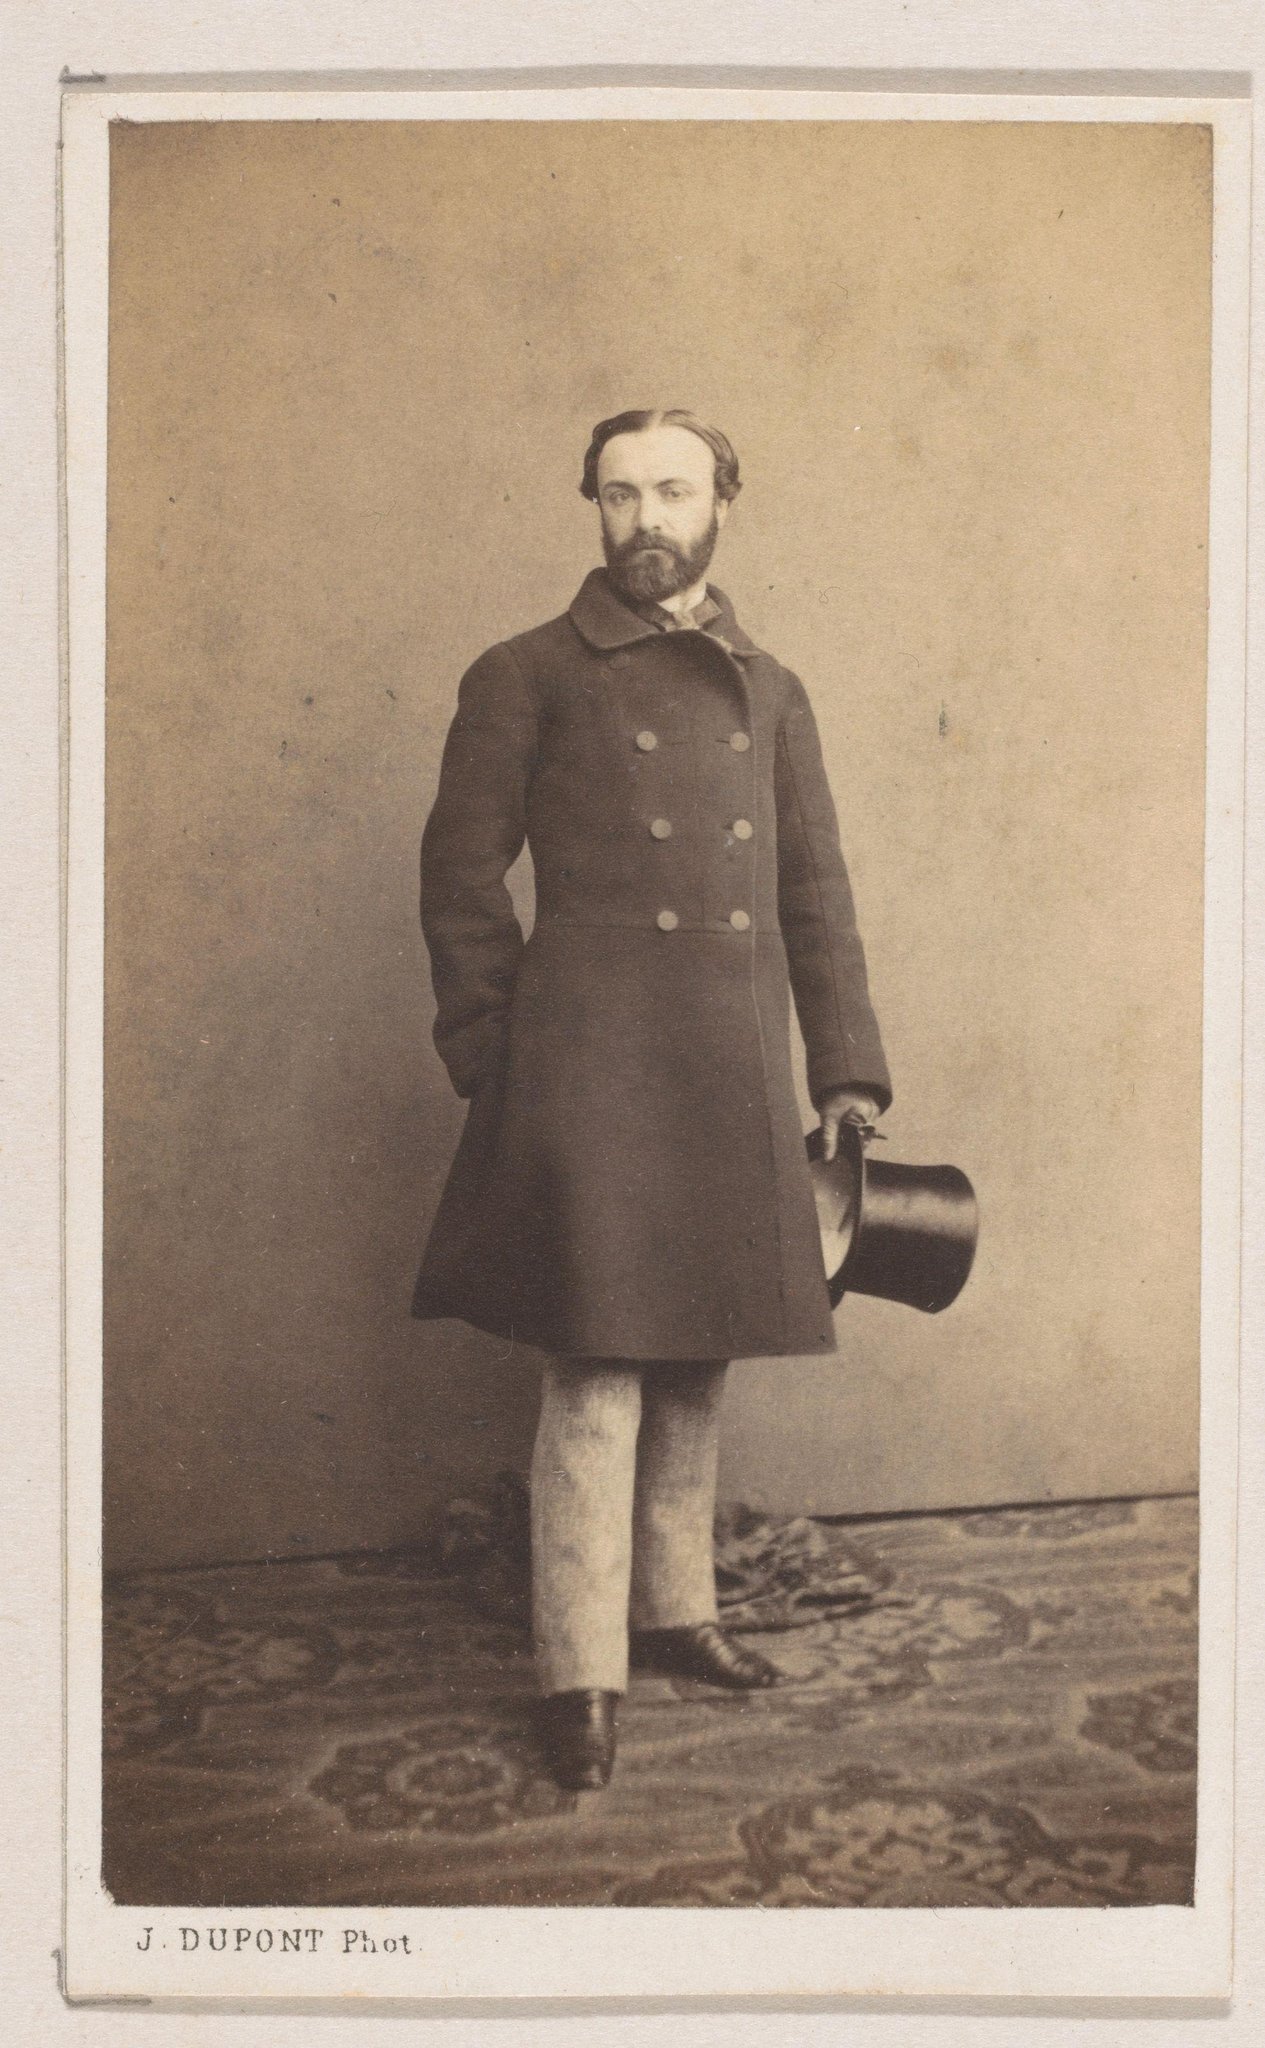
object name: carte de visite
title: L'École d'Anvers. Portraits biographies cartes de visite. Collection Dupont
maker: joseph dupont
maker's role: fotograaf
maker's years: 1818-1901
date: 1861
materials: cardboard, paper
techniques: albumen print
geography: antwerp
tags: antwerp, painter, charles verlat, historical persons, portrait, self-portrait of painter, portrait, self-portrait of artist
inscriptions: inscription: ‘Verlat’, inscription: ‘ETABLISSEMENT PHOTOGRAPHIQUE/ de/ J. DUPONT/ Place de Meir 32/ ANVERS/ Maison fondée en 1853’